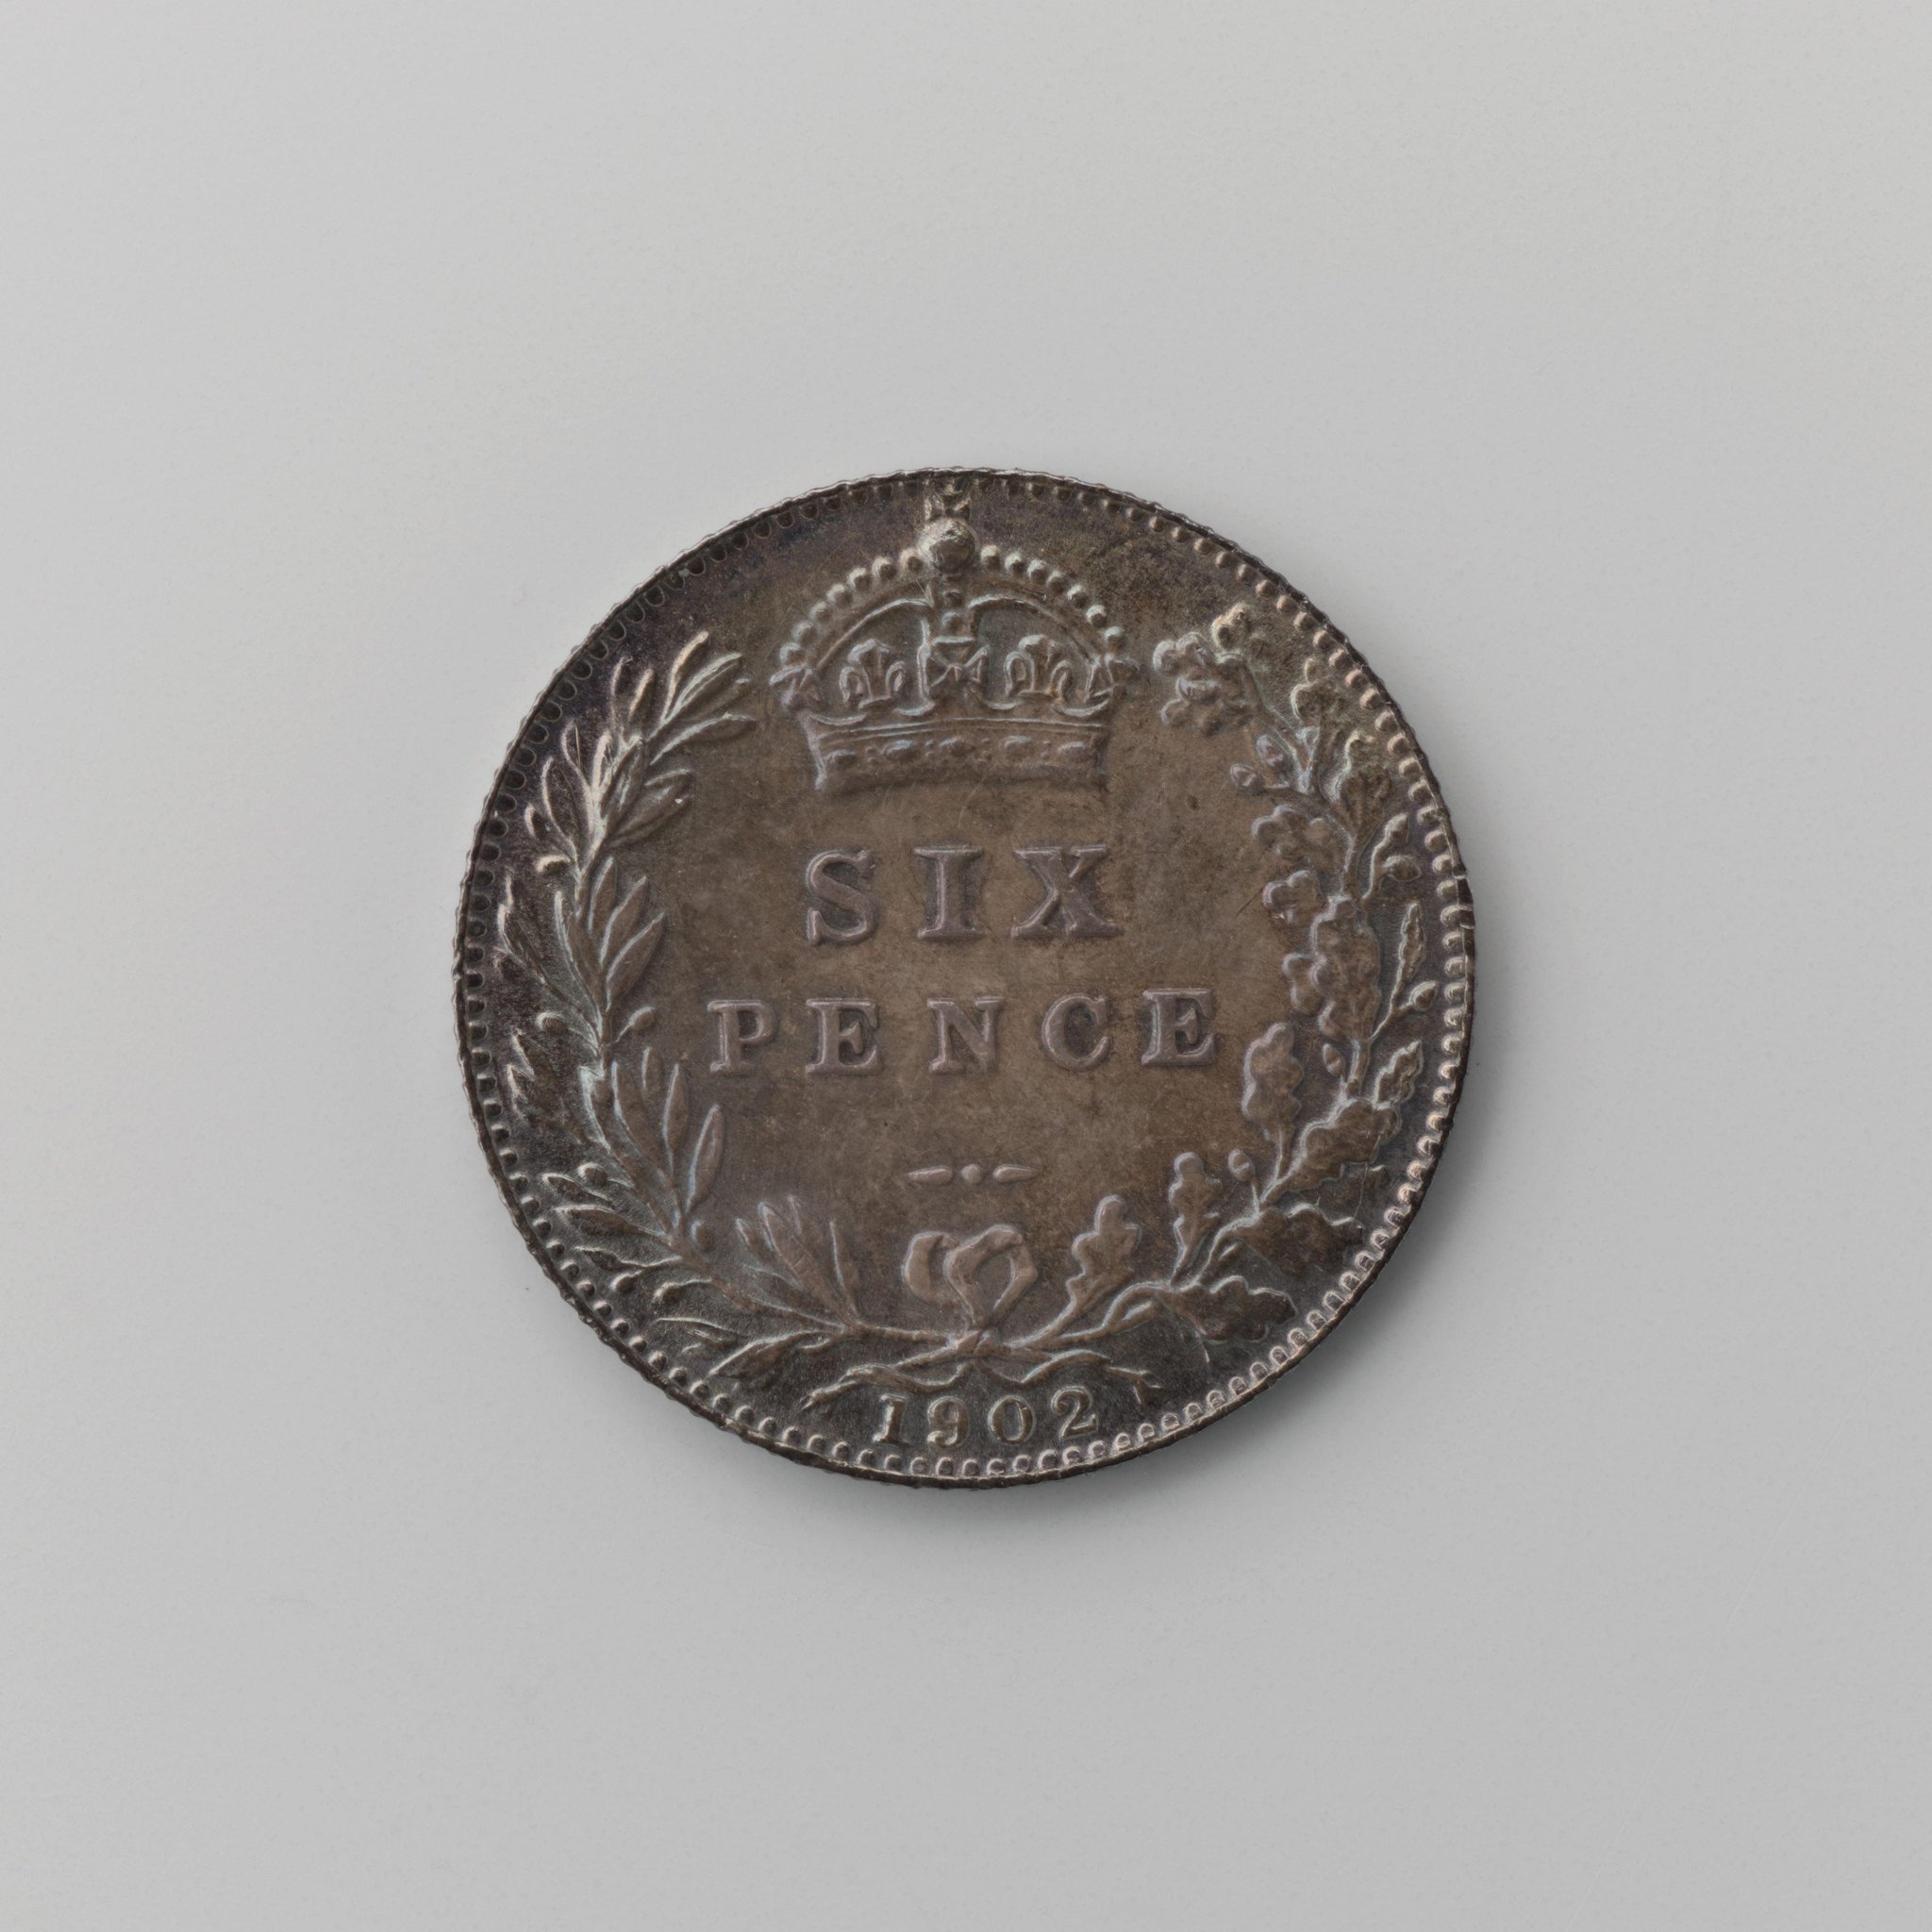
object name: coin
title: Engeland, Edward VII, 6 pence, 1902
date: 1902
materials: silver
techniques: striking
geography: london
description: Zilveren munt. Voorzijde: hoofd van de koning naar rechts. Keerzijde: binnen samengebonden laurier- en eikentak in twee regels waarde-aanduiding, waarboven kroon. Jaartal onderaan. Kartelrand.